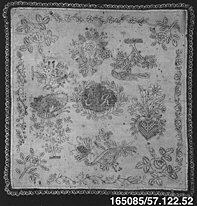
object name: sampler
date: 1801-1900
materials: cotton, linen, thread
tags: flowers,leaves